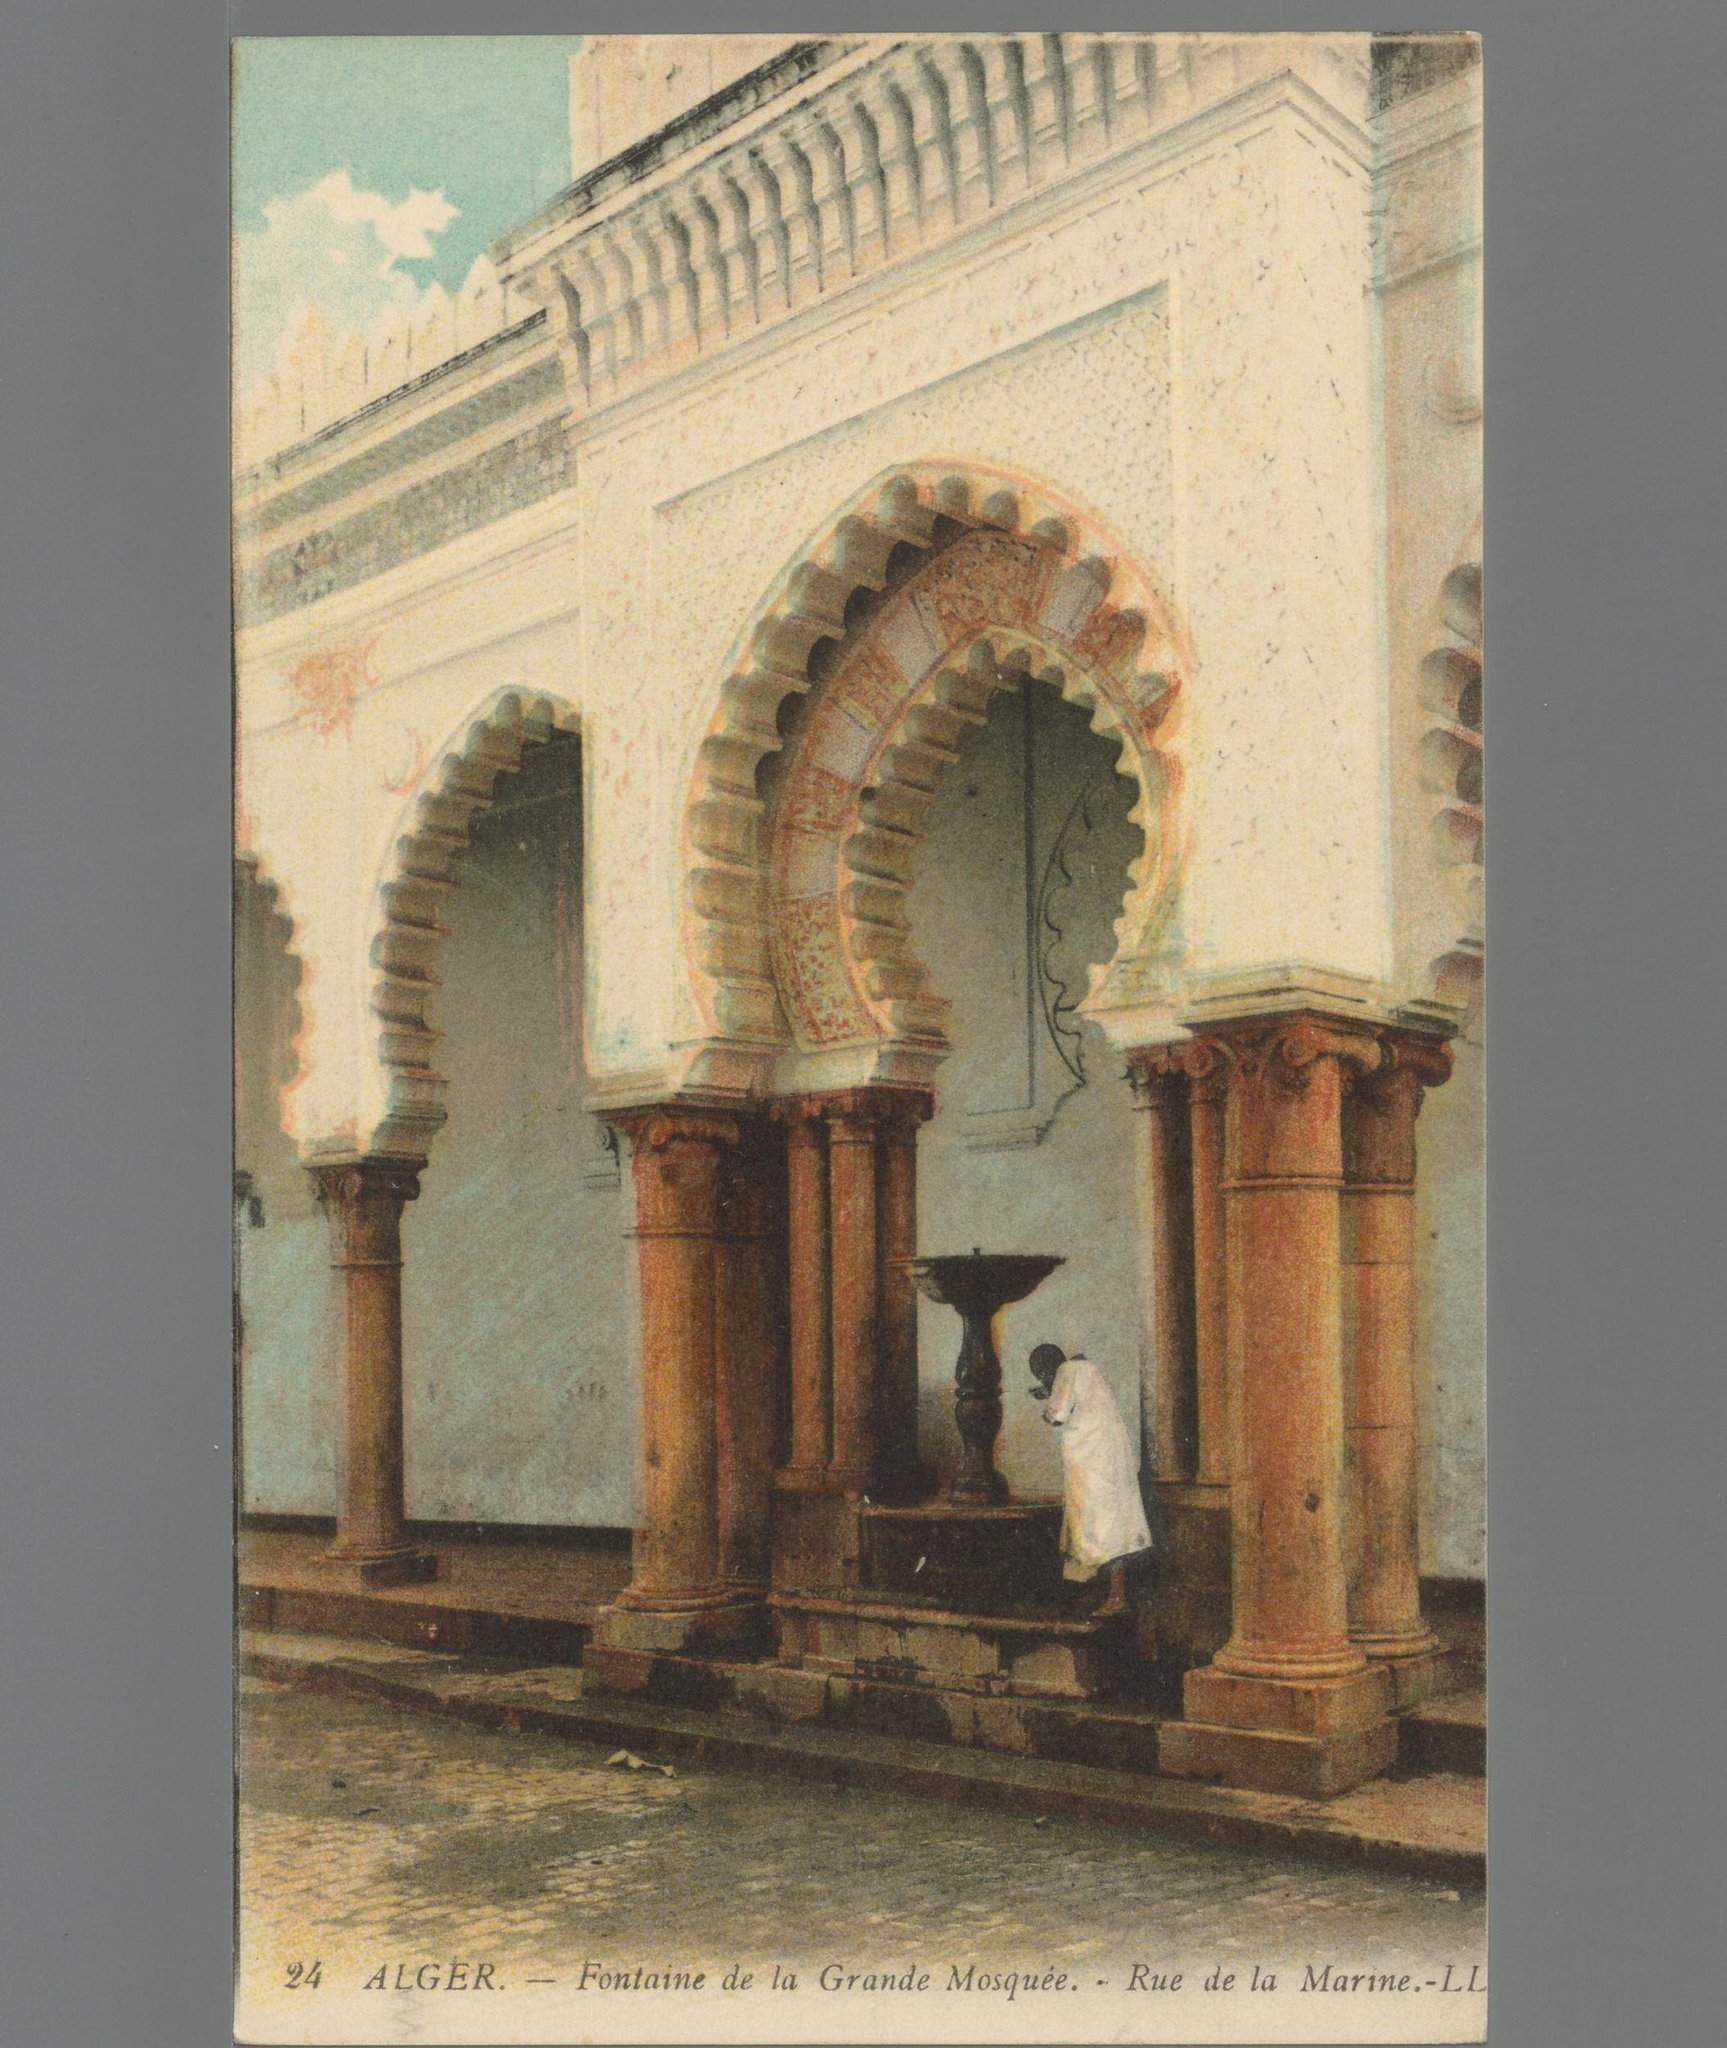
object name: ansichtkaart, prentbriefkaart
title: Alger. Fontaine de la Grande Mosquée. Rue de la Marine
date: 1903-1920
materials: cardboard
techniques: photograph, lithograph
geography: algiers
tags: street-trader, temple, shrine ~ islam, mohammedanism